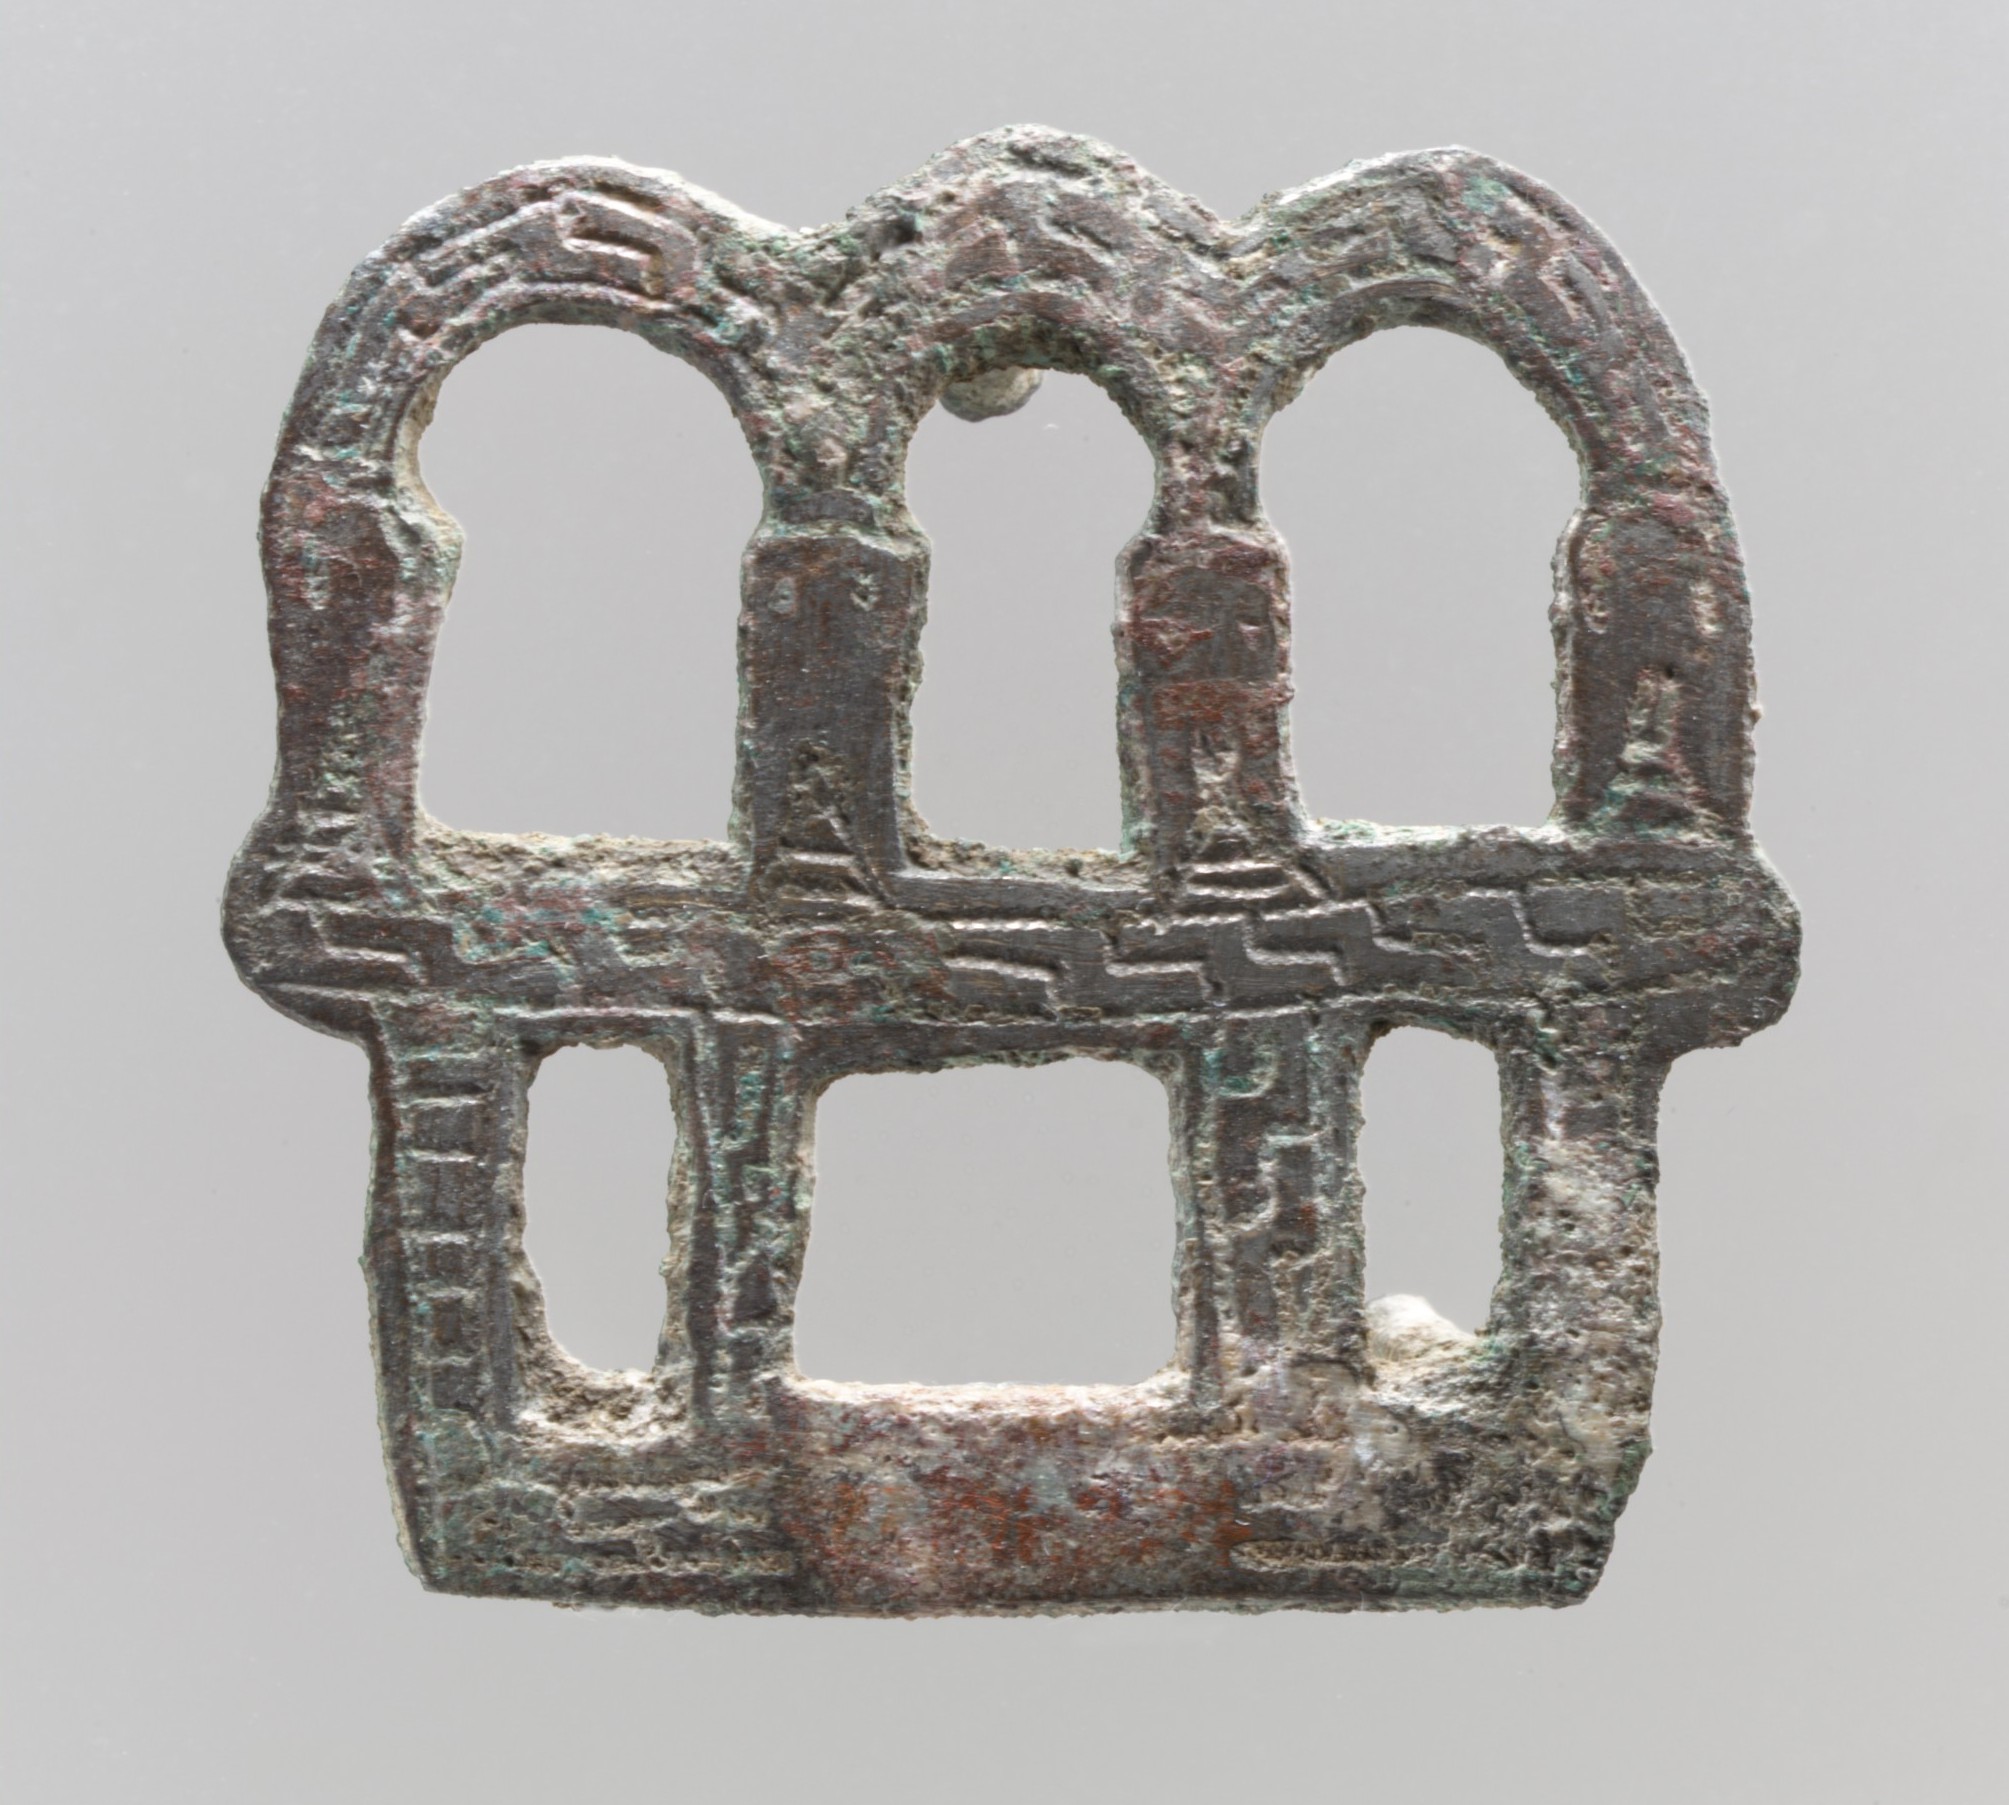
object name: plaque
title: Openwork Plaque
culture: frankish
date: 601-700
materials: copper alloy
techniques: silvered